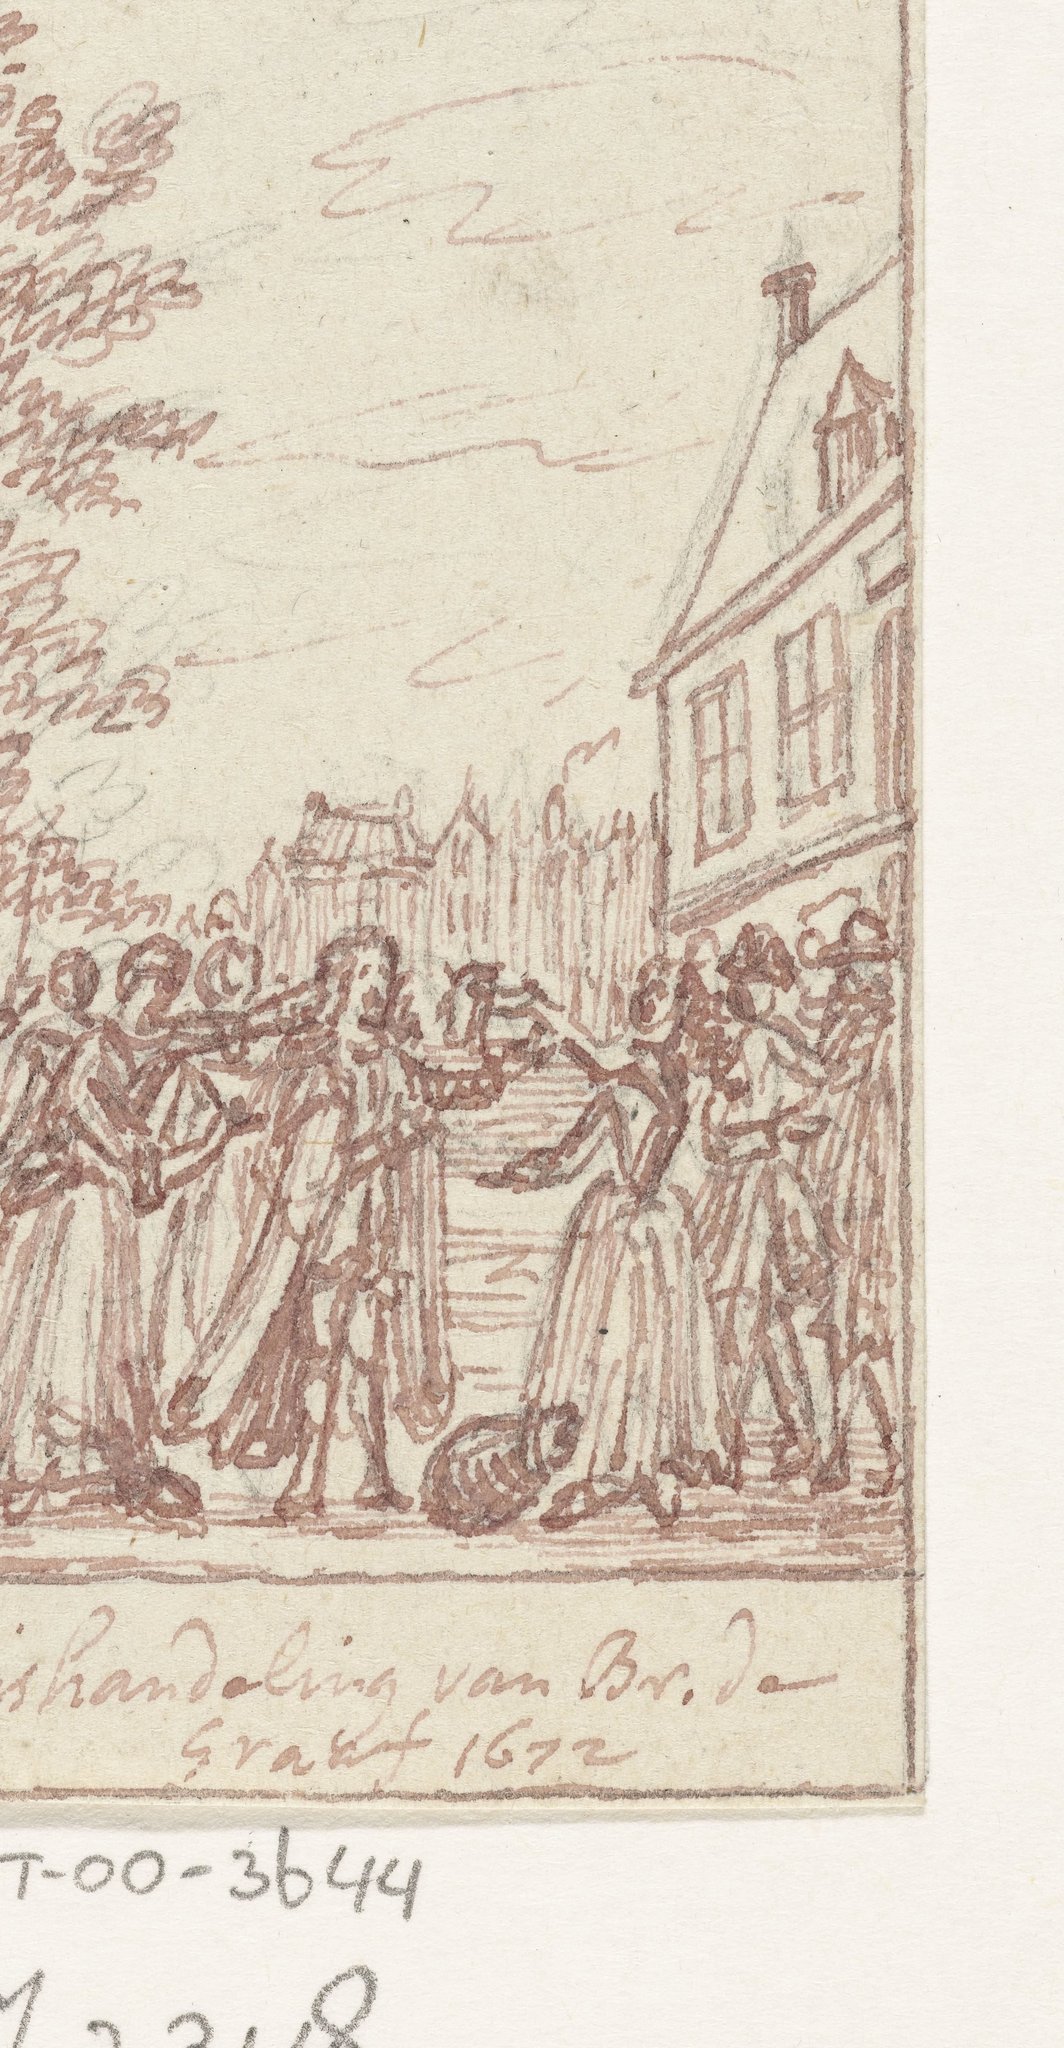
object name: drawing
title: Mishandeling van burgemeester Andries de Graaf, 1672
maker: simon fokke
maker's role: draughtsman, print maker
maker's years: 1712-1784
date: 1779-1781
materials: paper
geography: northern netherlands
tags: mayor, amsterdam, rampjaar (disaster year)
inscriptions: inscription: ‘Mishandeling van Br. de Graaf, 1672’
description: Mogelijk ontwerp voor illustratie in: Jacobus Kok, Amsteldamsche jaarboeken, behelzende de merkwaardigste geschiedenissen, welken, zo binnen de stad als daaromtrent, zijn voorgevallen, sedert haare eerste beginselen, tot op den tegenwoordigen tijd ... / Bijeengebragt door Jacobus Kok, 3 dln., J.B. Elwe, Amsterdam 1781.